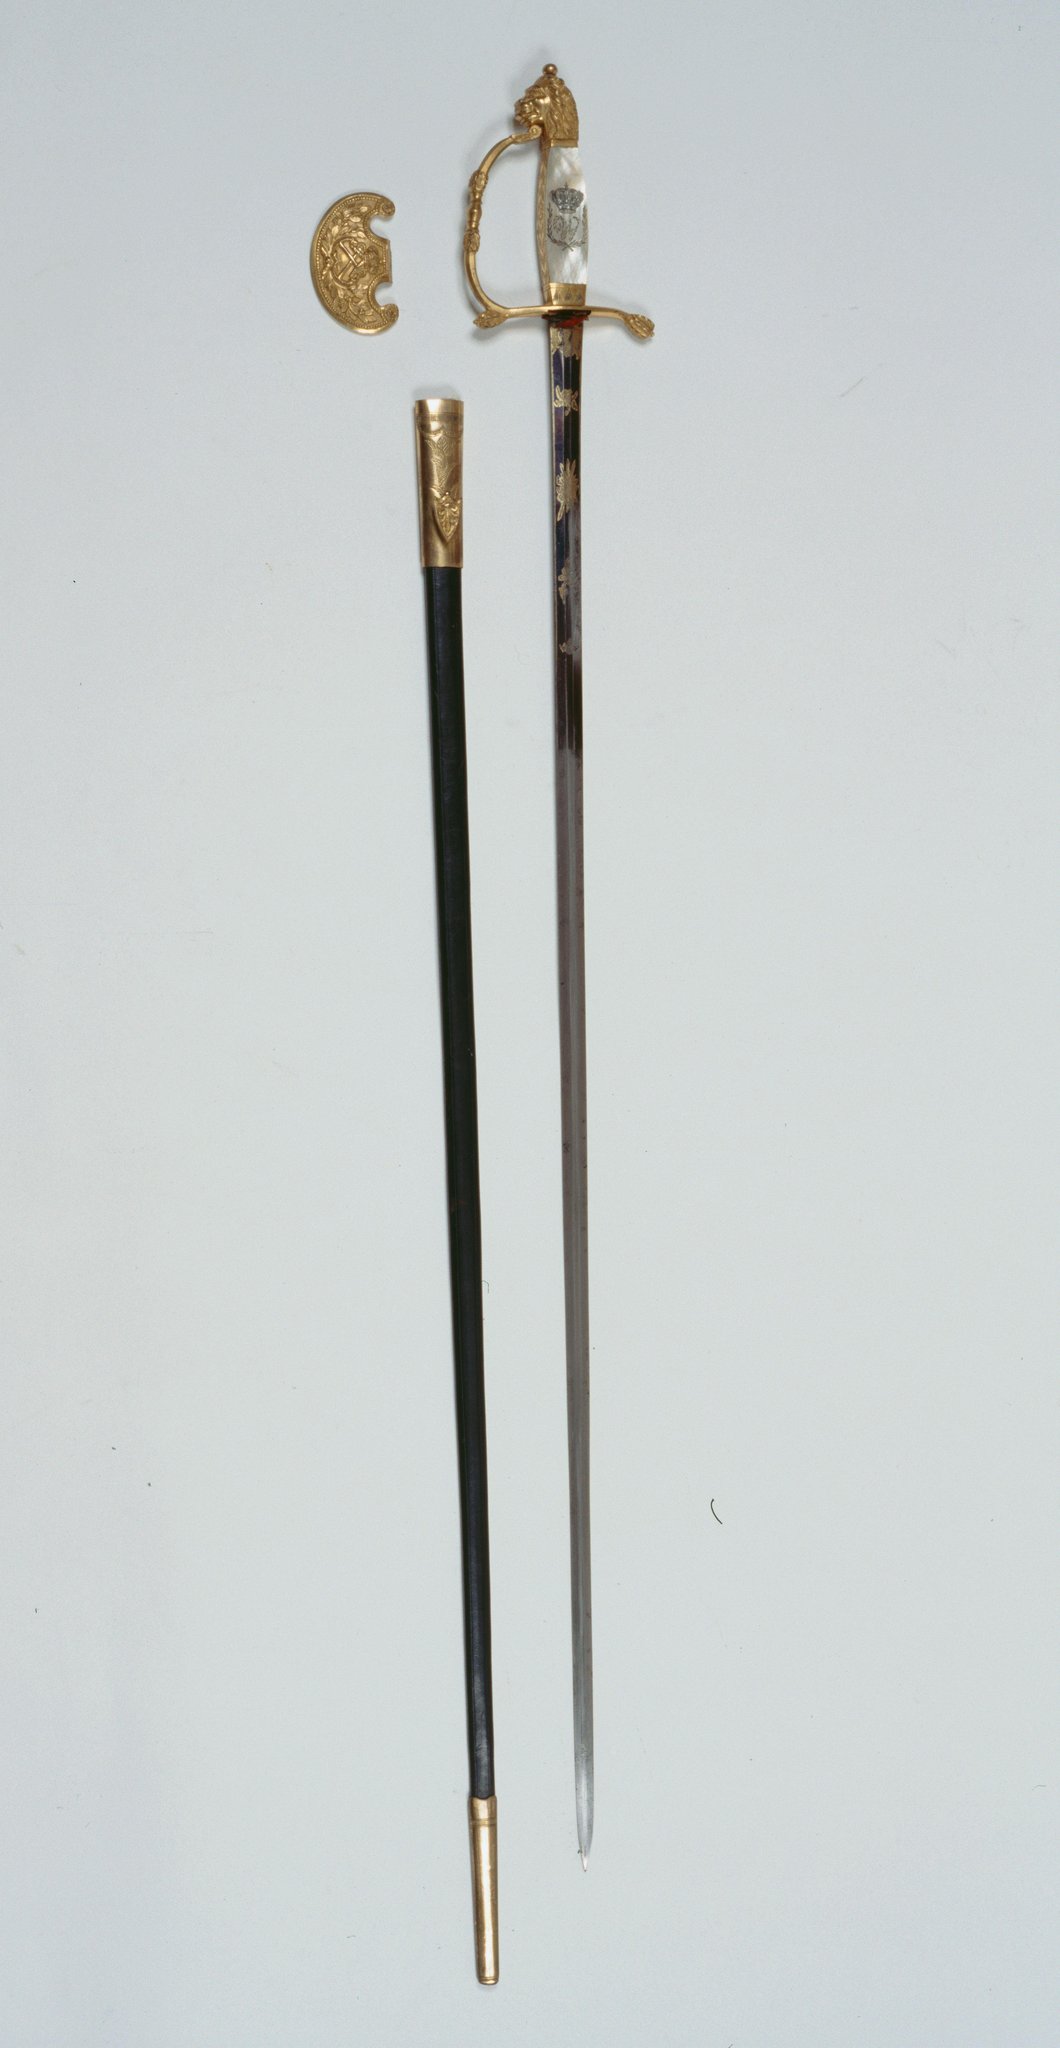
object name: sword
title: Staande degen met schede voor zee-officieren M 1824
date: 1824-1843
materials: brass, iron, leather, mother of pearl, wood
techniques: engraving, gilding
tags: netherlands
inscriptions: monogram: ‘S & K’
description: Staande degen voor zee-officieren M 1824. De kling gedeeltelijk geblauwd, verguld gegraveerd, een zijde inscriptie van gekroonde W en de letters F en K. Het gevest van messing en op de stootplaat twee gekruiste ankers. De greep is met parelmoer bekleed. Met zwart houten schede met messing banden en haak. De steekplaat is afgebroken, gesigneerd. Gedragen door vice-admiraal A.A. Buijskes.